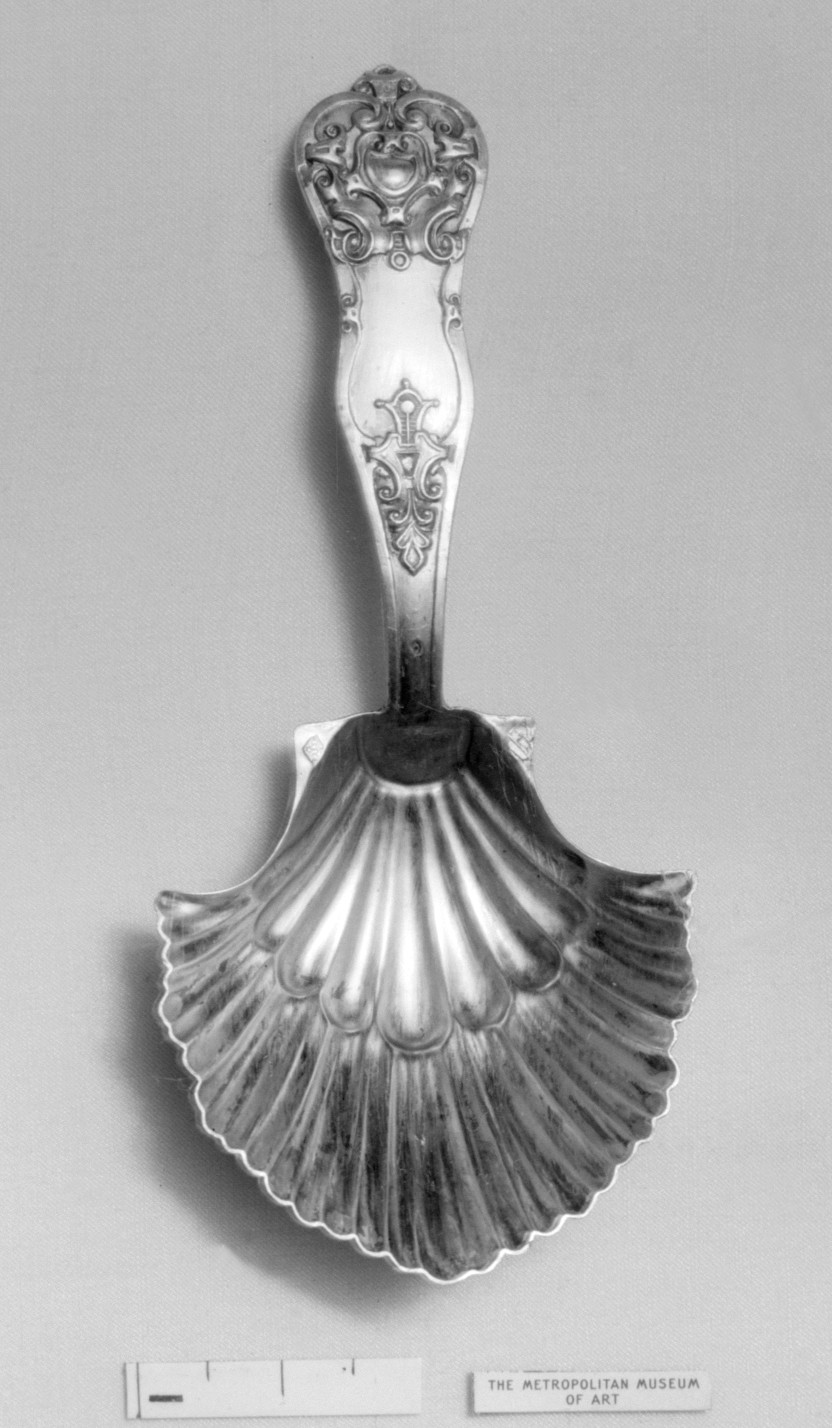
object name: caddy spoon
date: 1801-1833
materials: silver